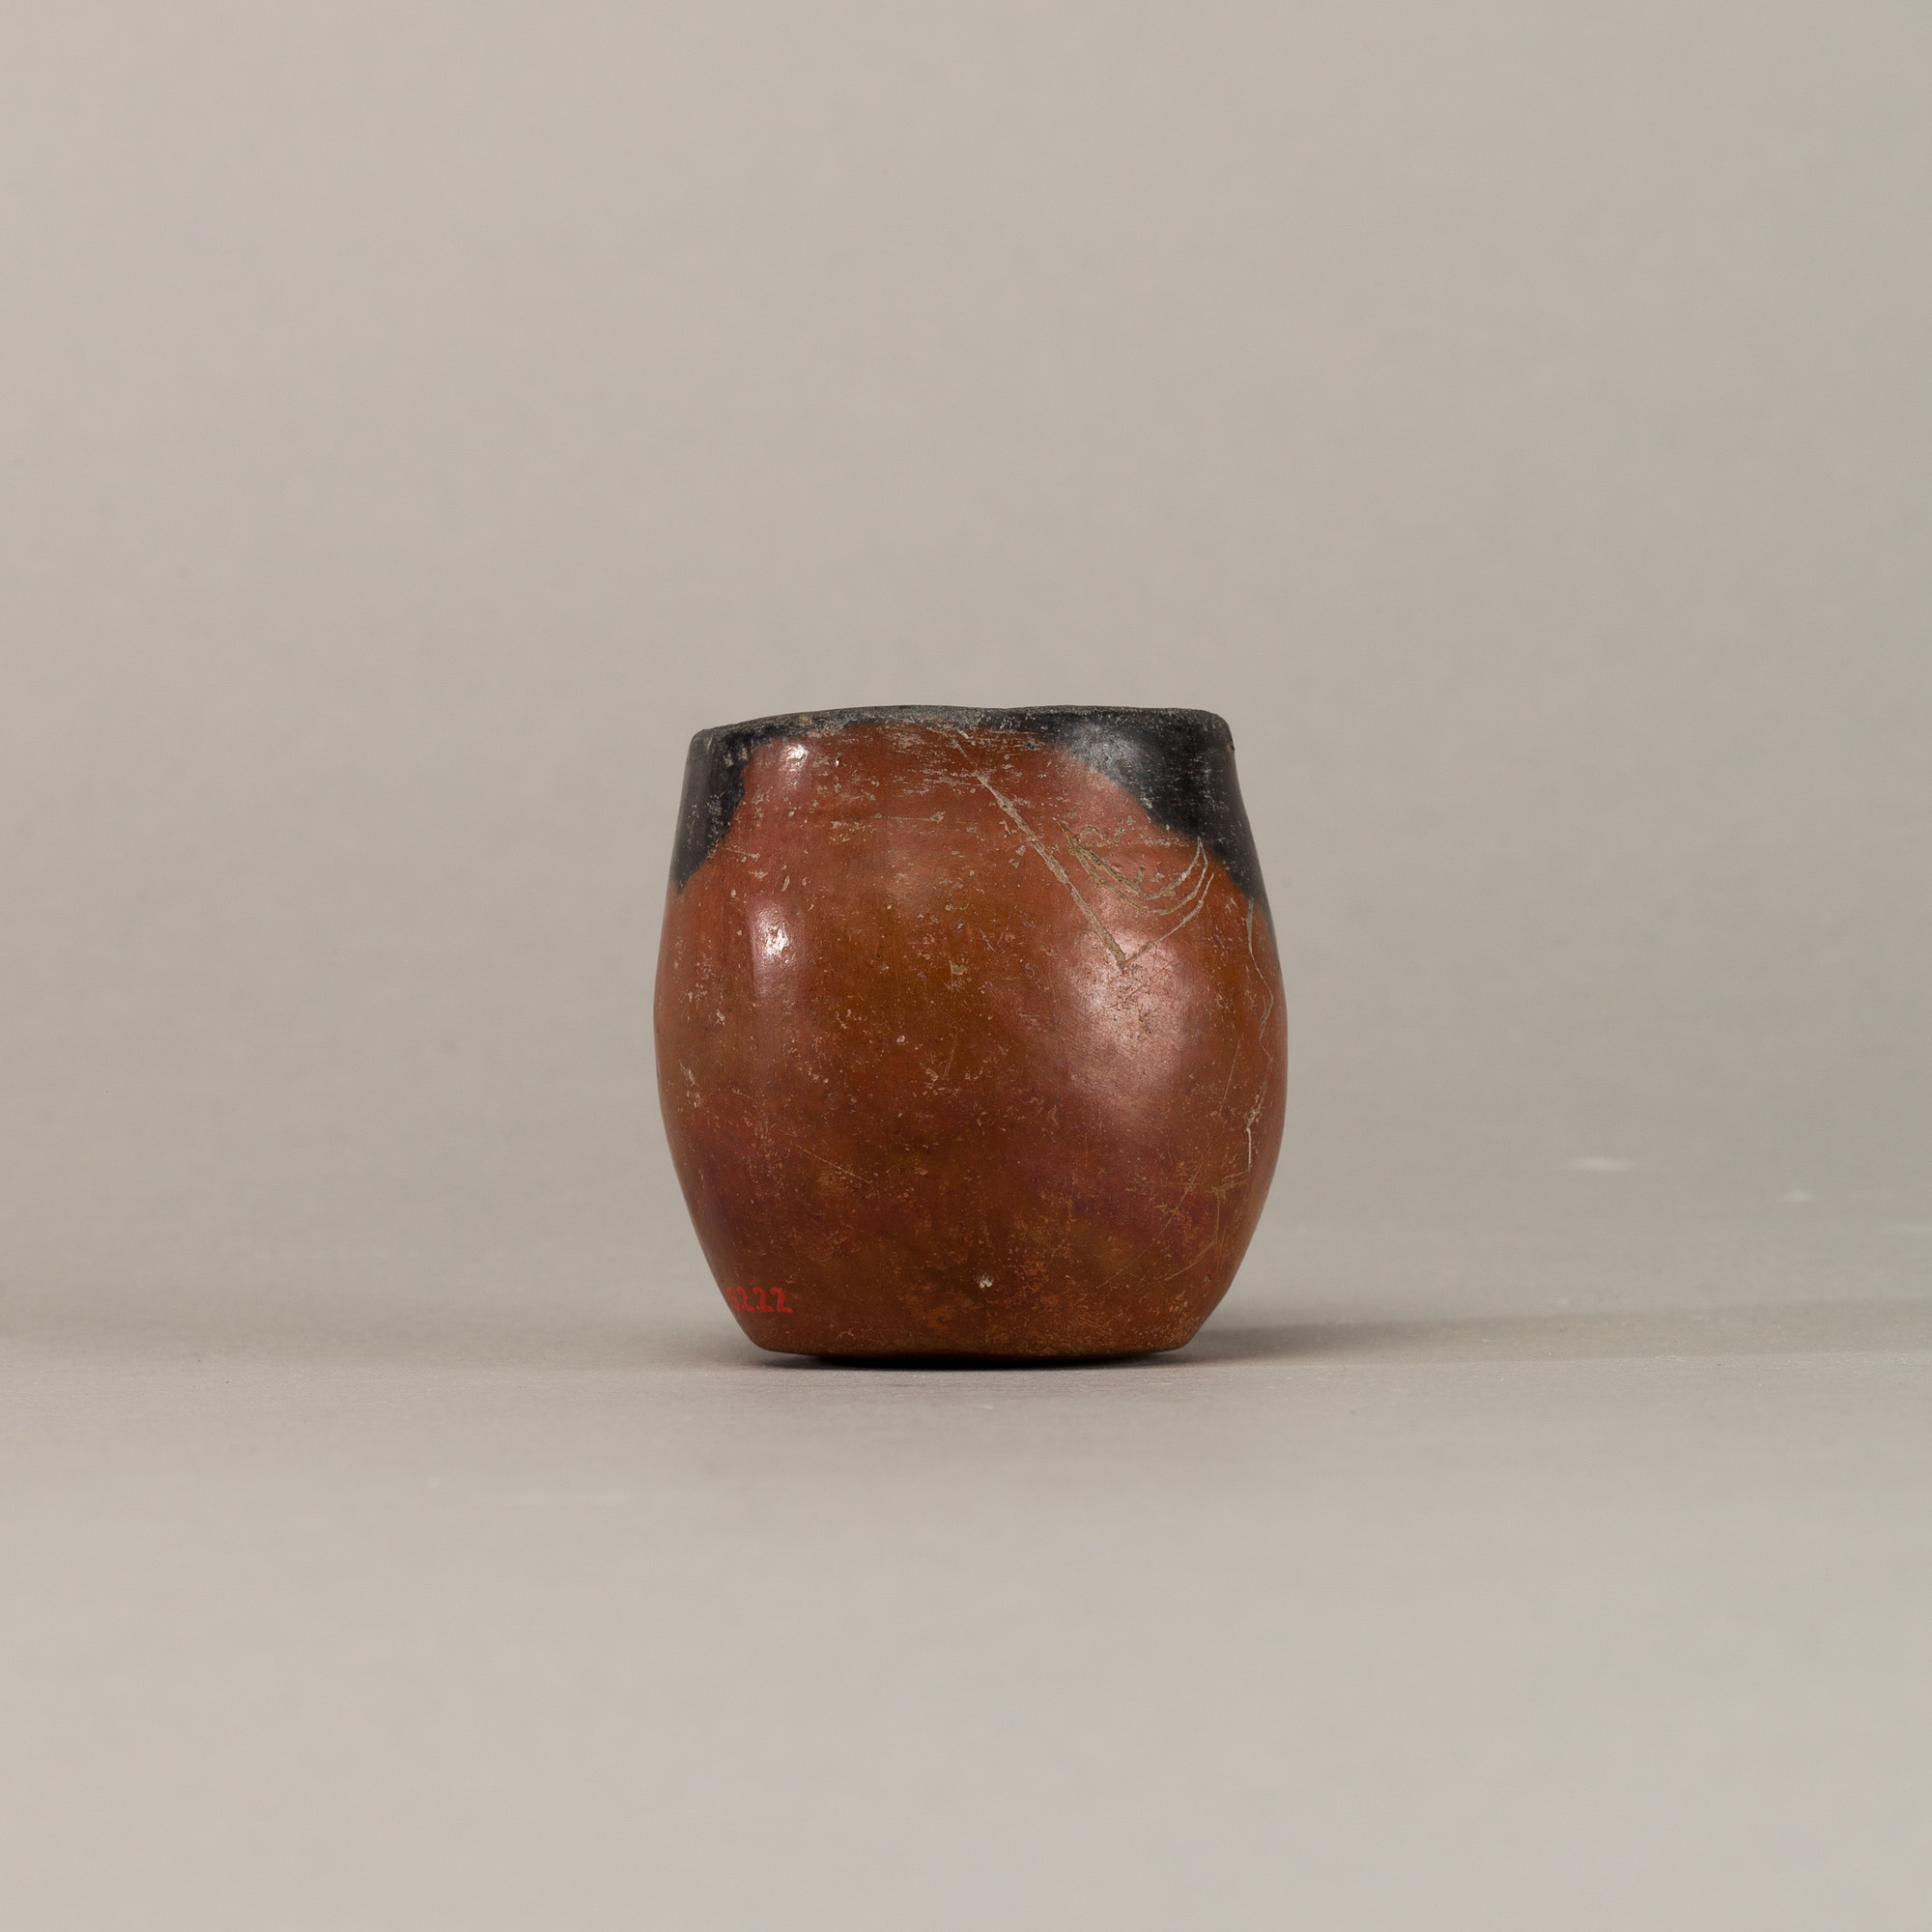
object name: jar, red polished ware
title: Red polished ware jar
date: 3850-2960 BCE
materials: pottery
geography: egypt